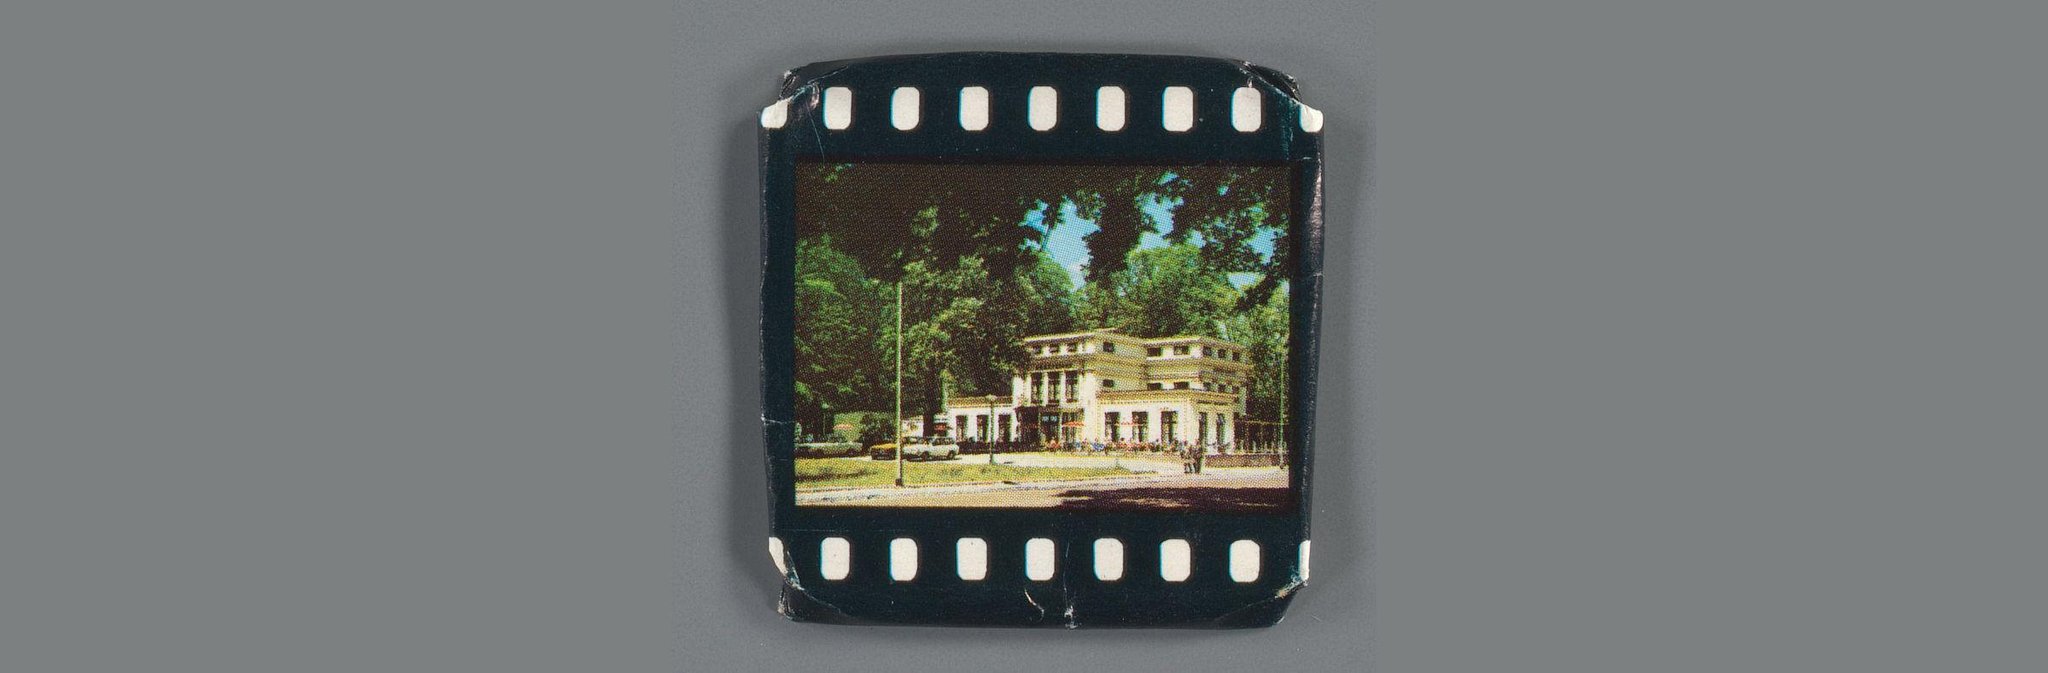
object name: photomechanical print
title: Wikkel in de vorm van een filmstrip, met een voorstelling van restaurant Dreefzicht te Haarlem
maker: Anonymous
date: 1950-1980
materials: paper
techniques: offset printed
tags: restaurant, haarlem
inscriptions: inscription: ‘Café-restaurant/ "Dreefzicht"/ Fonteinlaan 1/ Haarlem/ Tel. 023-32 43 32’